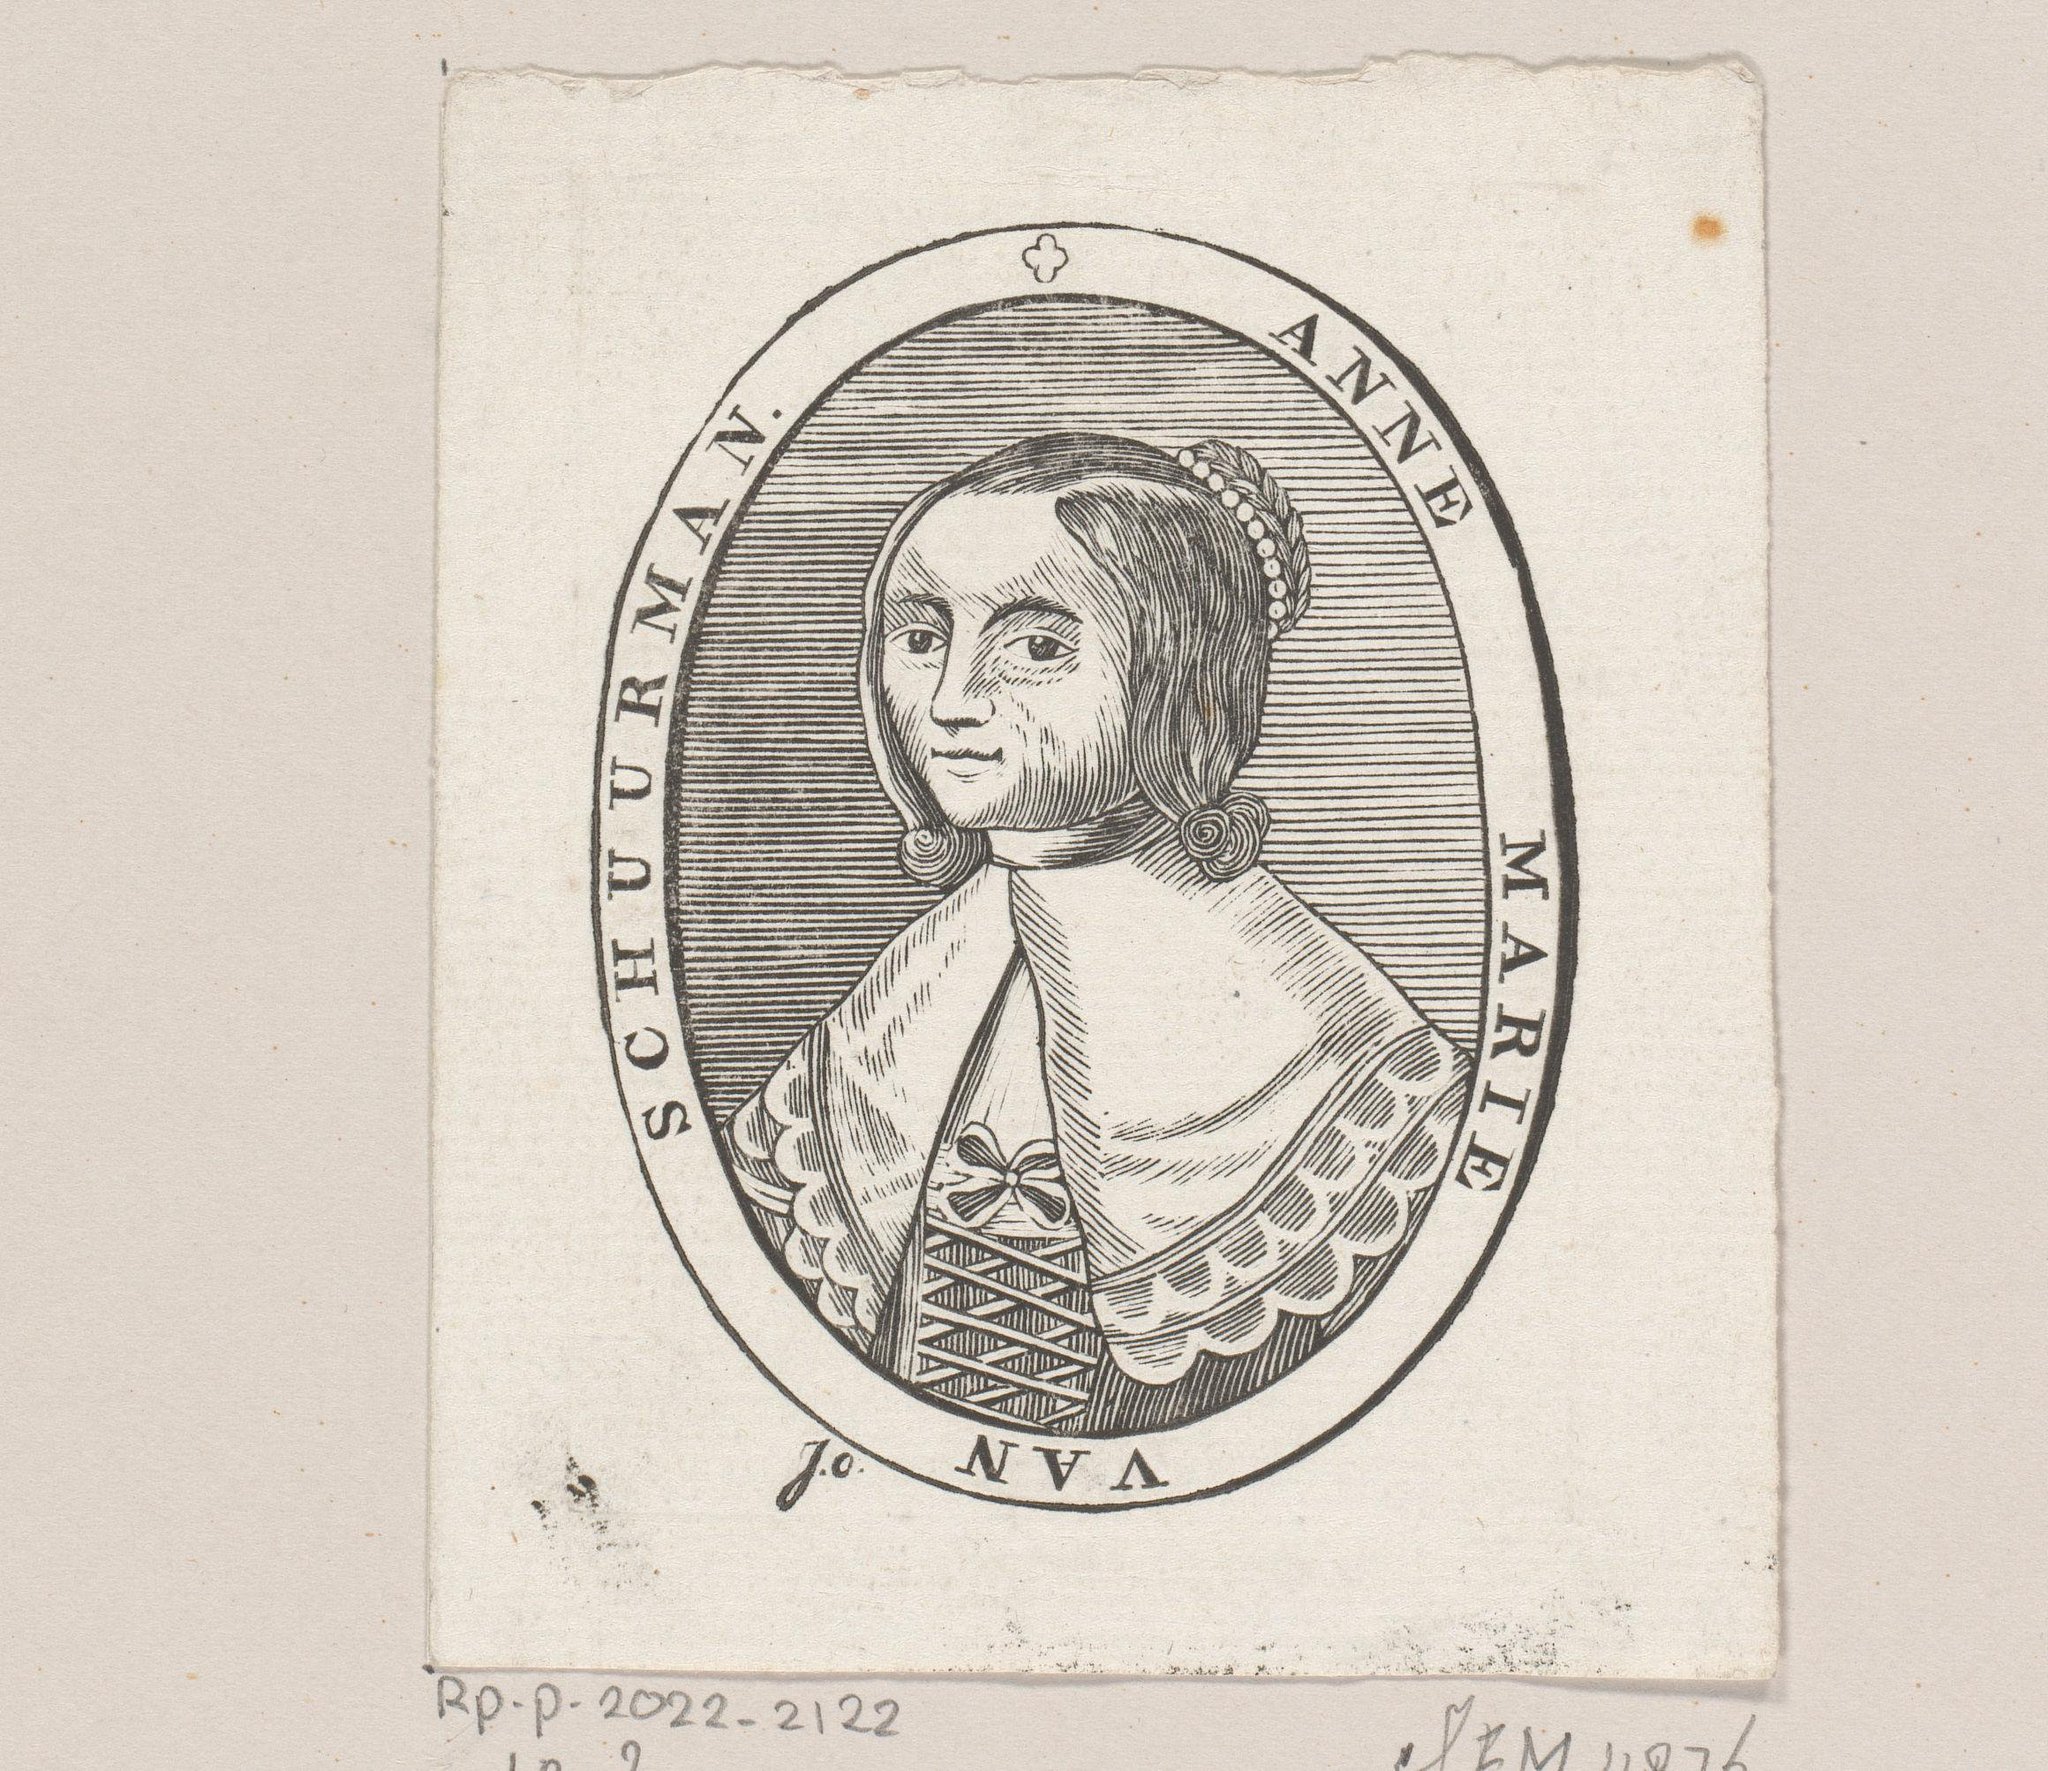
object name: print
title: Portret van Anna Maria van Schurman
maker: Anonymous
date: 1640-1799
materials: paper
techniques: woodcut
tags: print maker, draughtsman, anna maria van schurman, historical persons - bb - woman, portrait, self-portrait of artist, writer, poet, author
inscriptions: initials: ‘J.o.’